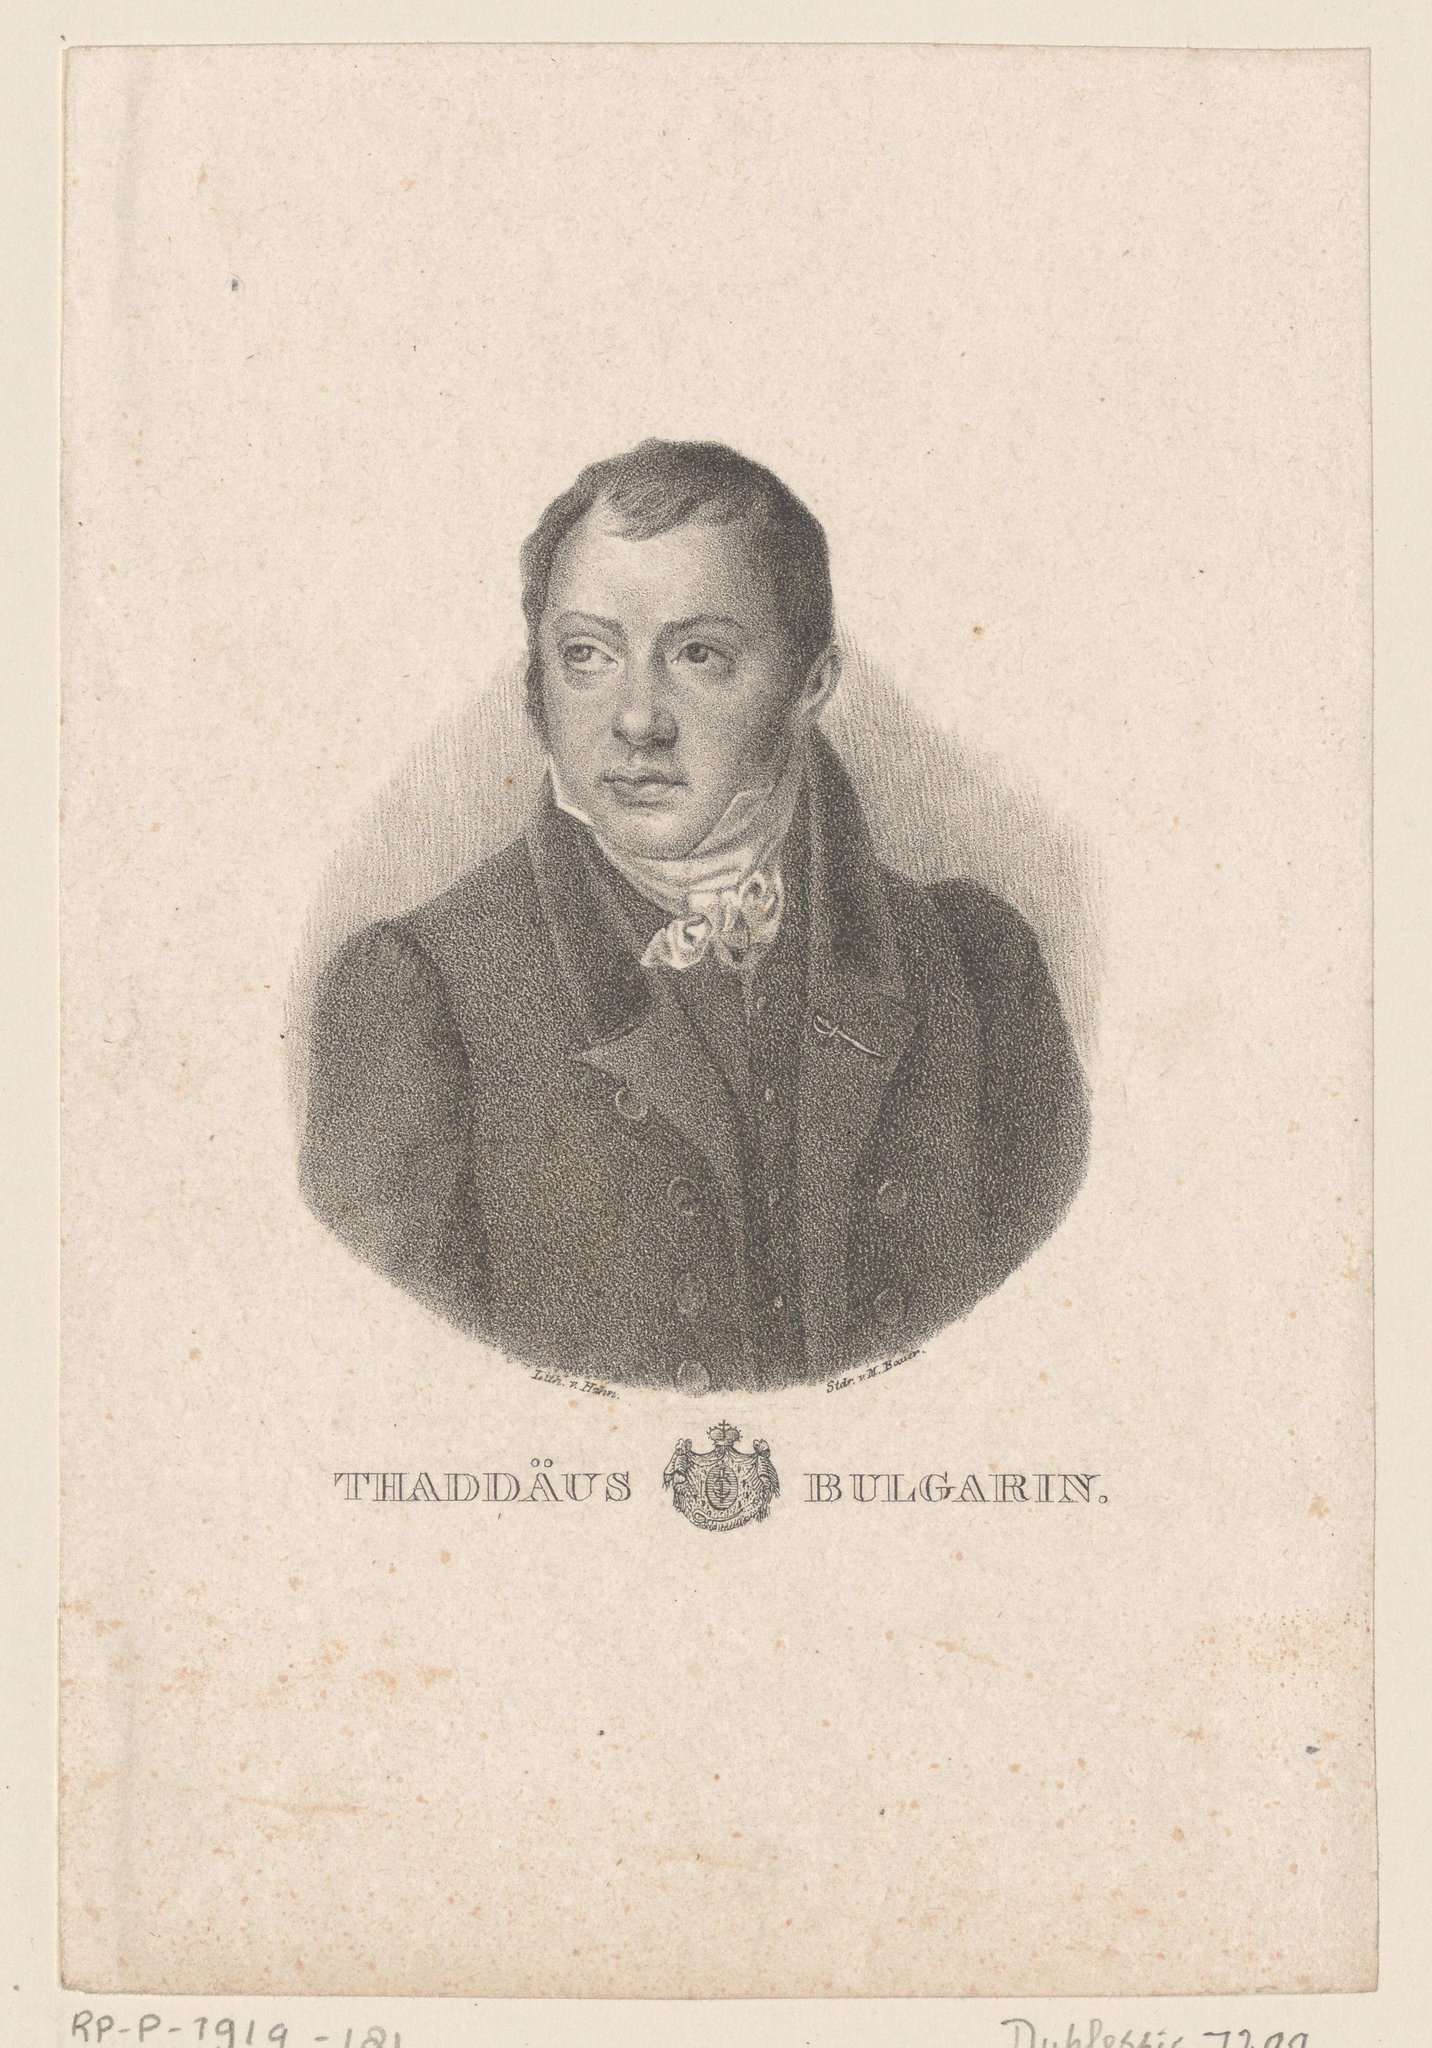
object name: print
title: Portret van Thaddeus Bulgarin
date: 1825-1874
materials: paper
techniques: lithograph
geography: leipzig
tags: historical persons, portrait of a writer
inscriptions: collector's mark: Lugt 2228